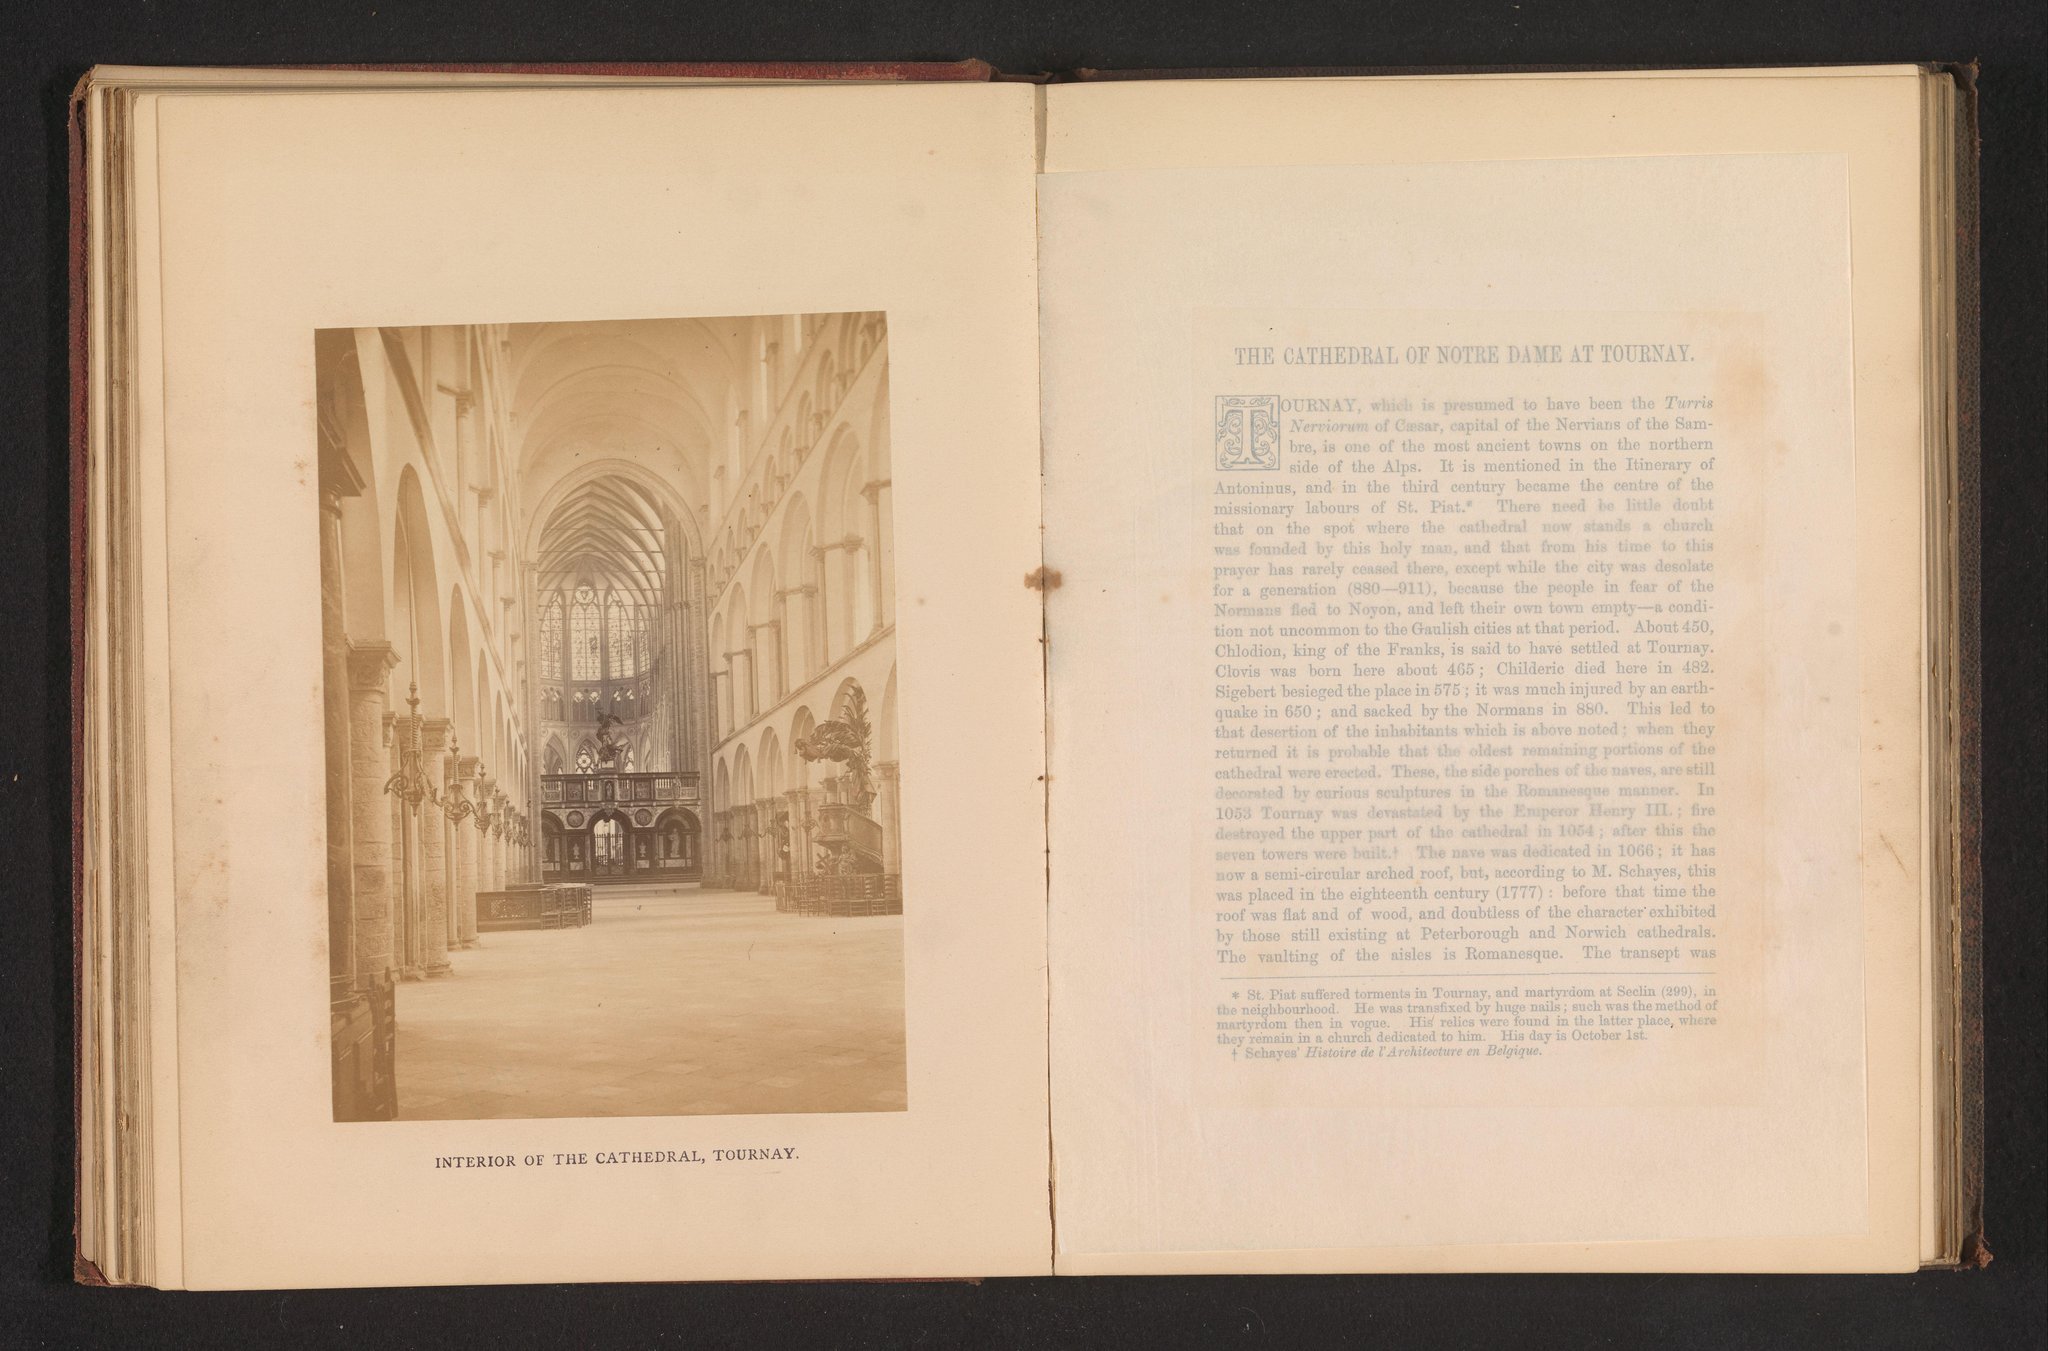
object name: photograph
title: Interior of the cathedral, Tournay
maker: Anonymous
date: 1856-1866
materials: photographic support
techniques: albumen print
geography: tournai cathedral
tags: parts of church interior: aisle, interior of church